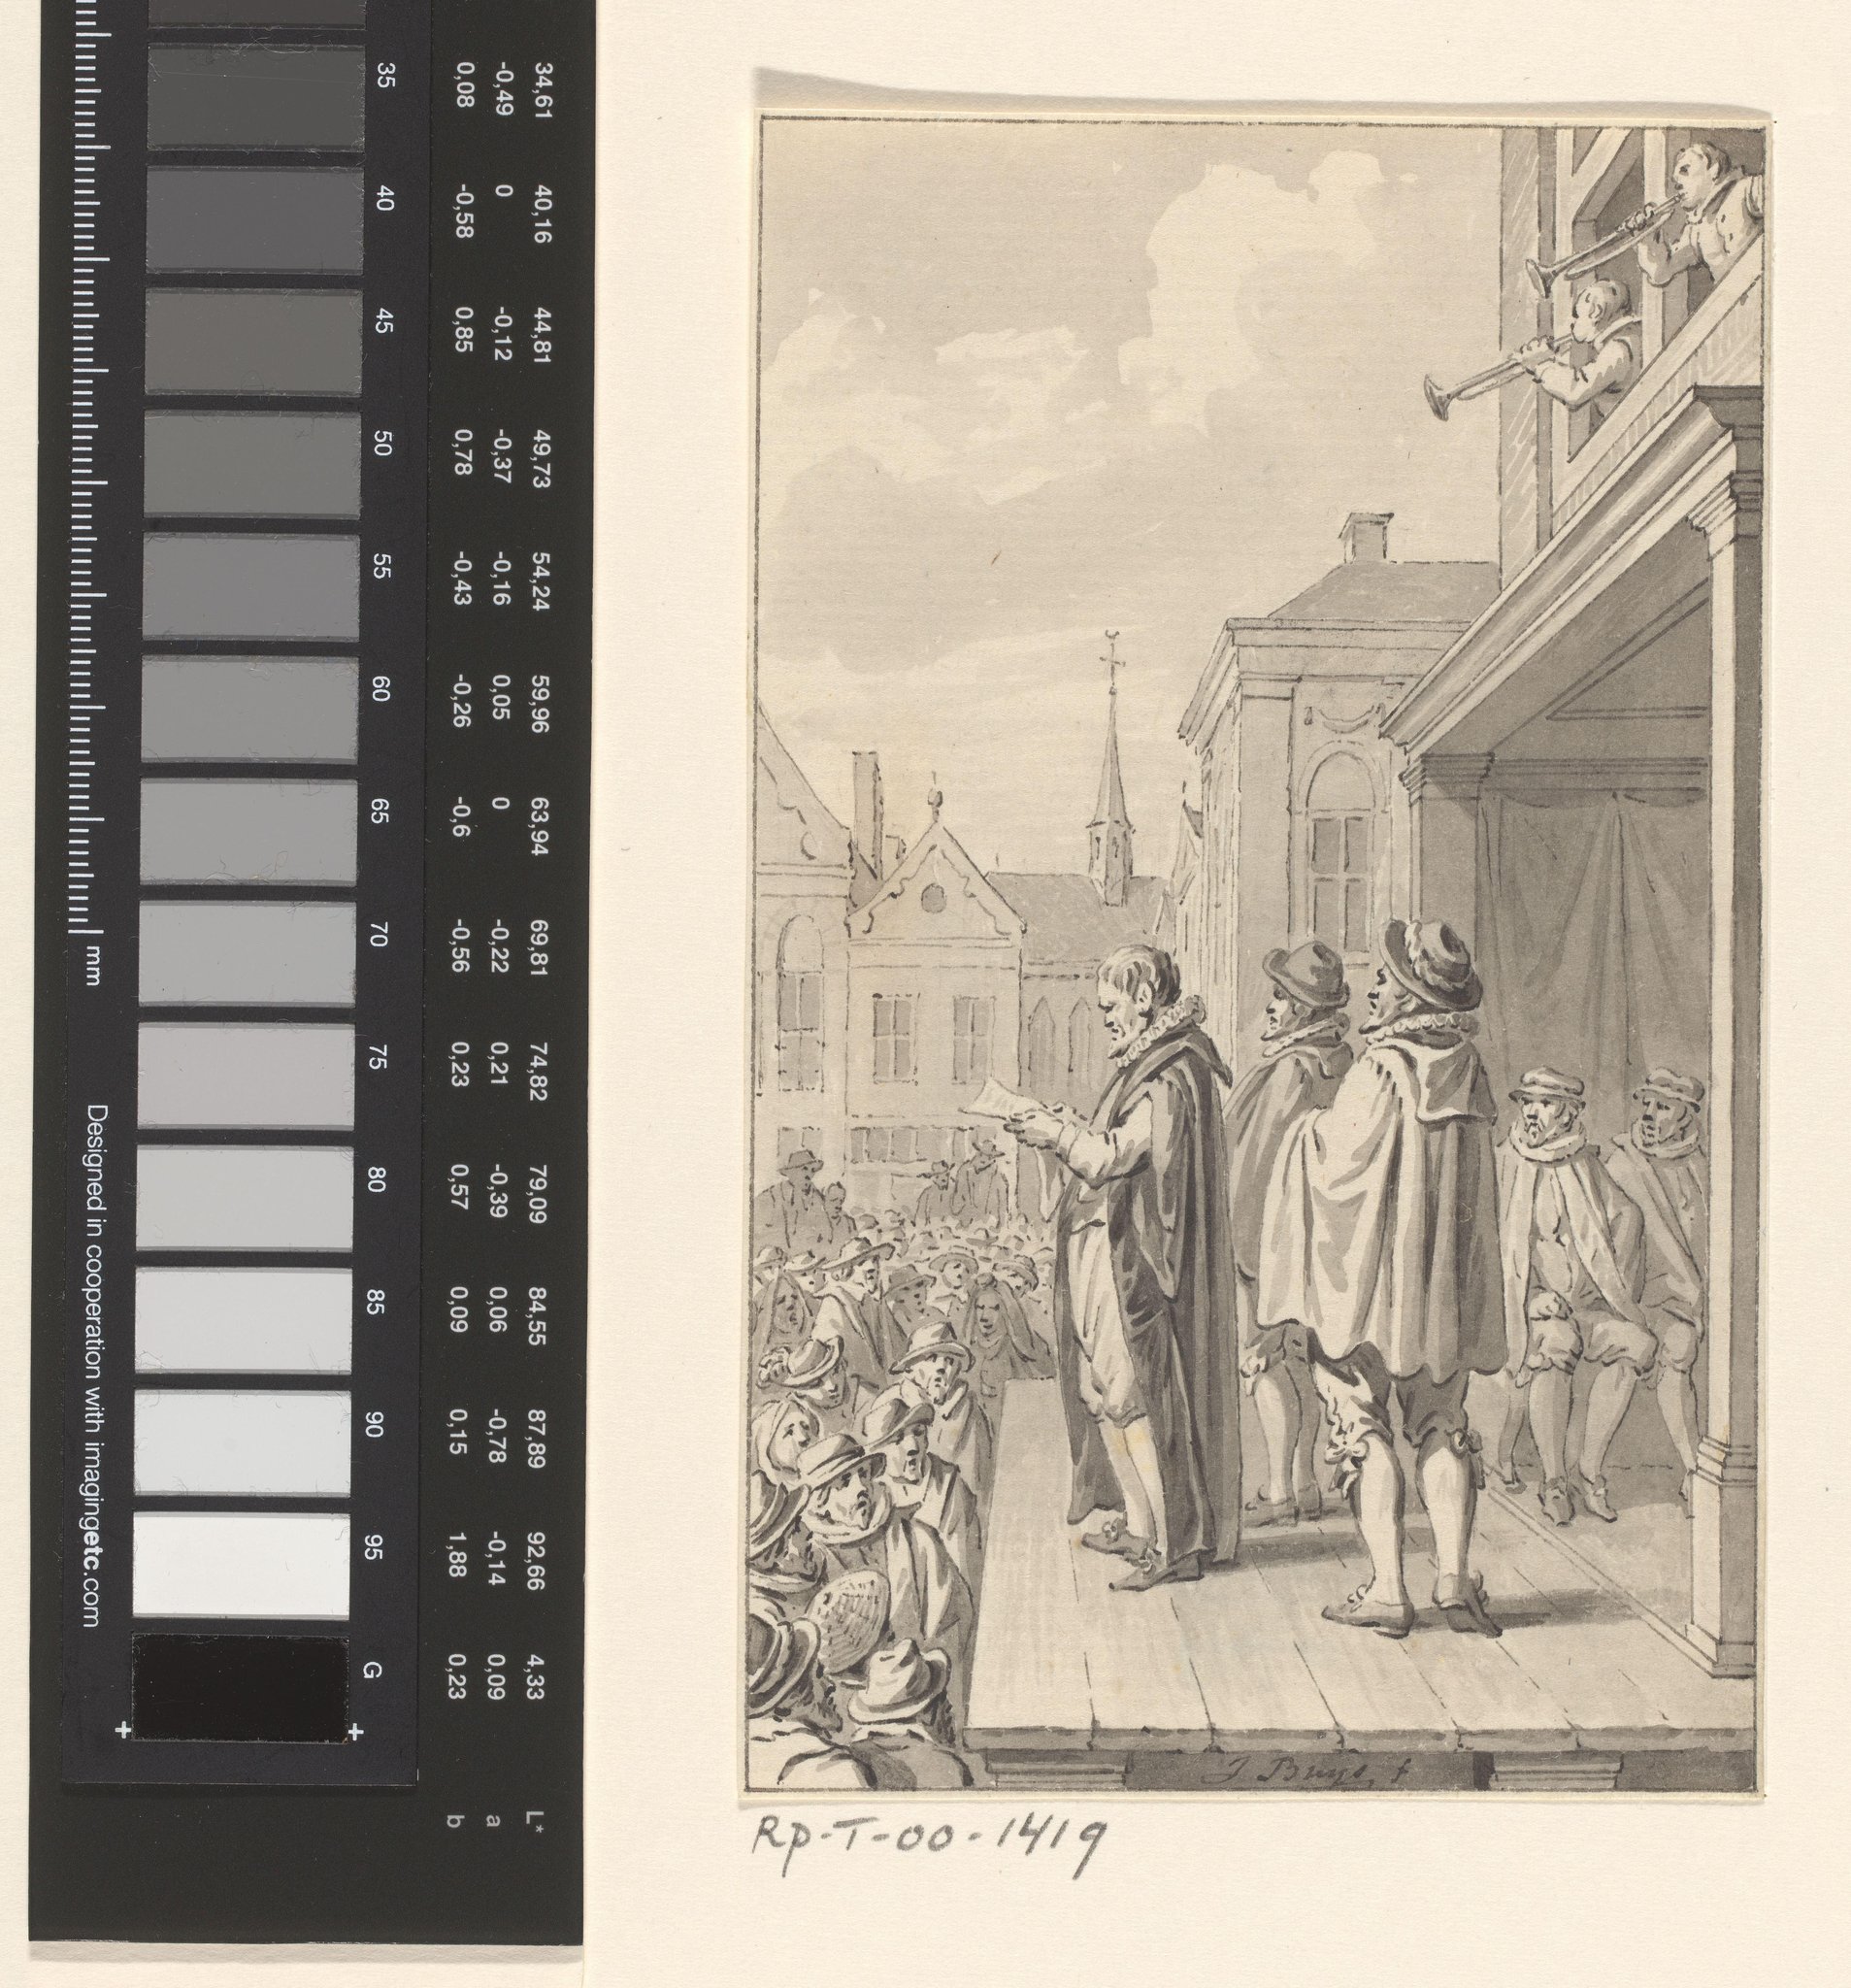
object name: design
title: Afkondiging van de Pacificatie van Gent, 1576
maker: jacobus buys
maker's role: draughtsman, print maker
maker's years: 1724-1801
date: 1785-1787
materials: ink, paper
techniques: brush, pen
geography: netherlands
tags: proclamation of peace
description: Bekendmaking van het ondertekenen van de Pacificatie van Gent op 8 november 1576. Op een stellage wordt aan het aanwezige publiek de vrede bekend gemaakt en voorgelezen. Uit de ramen blazen twee mannen op bazuinen. Ontwerp voor een prent.